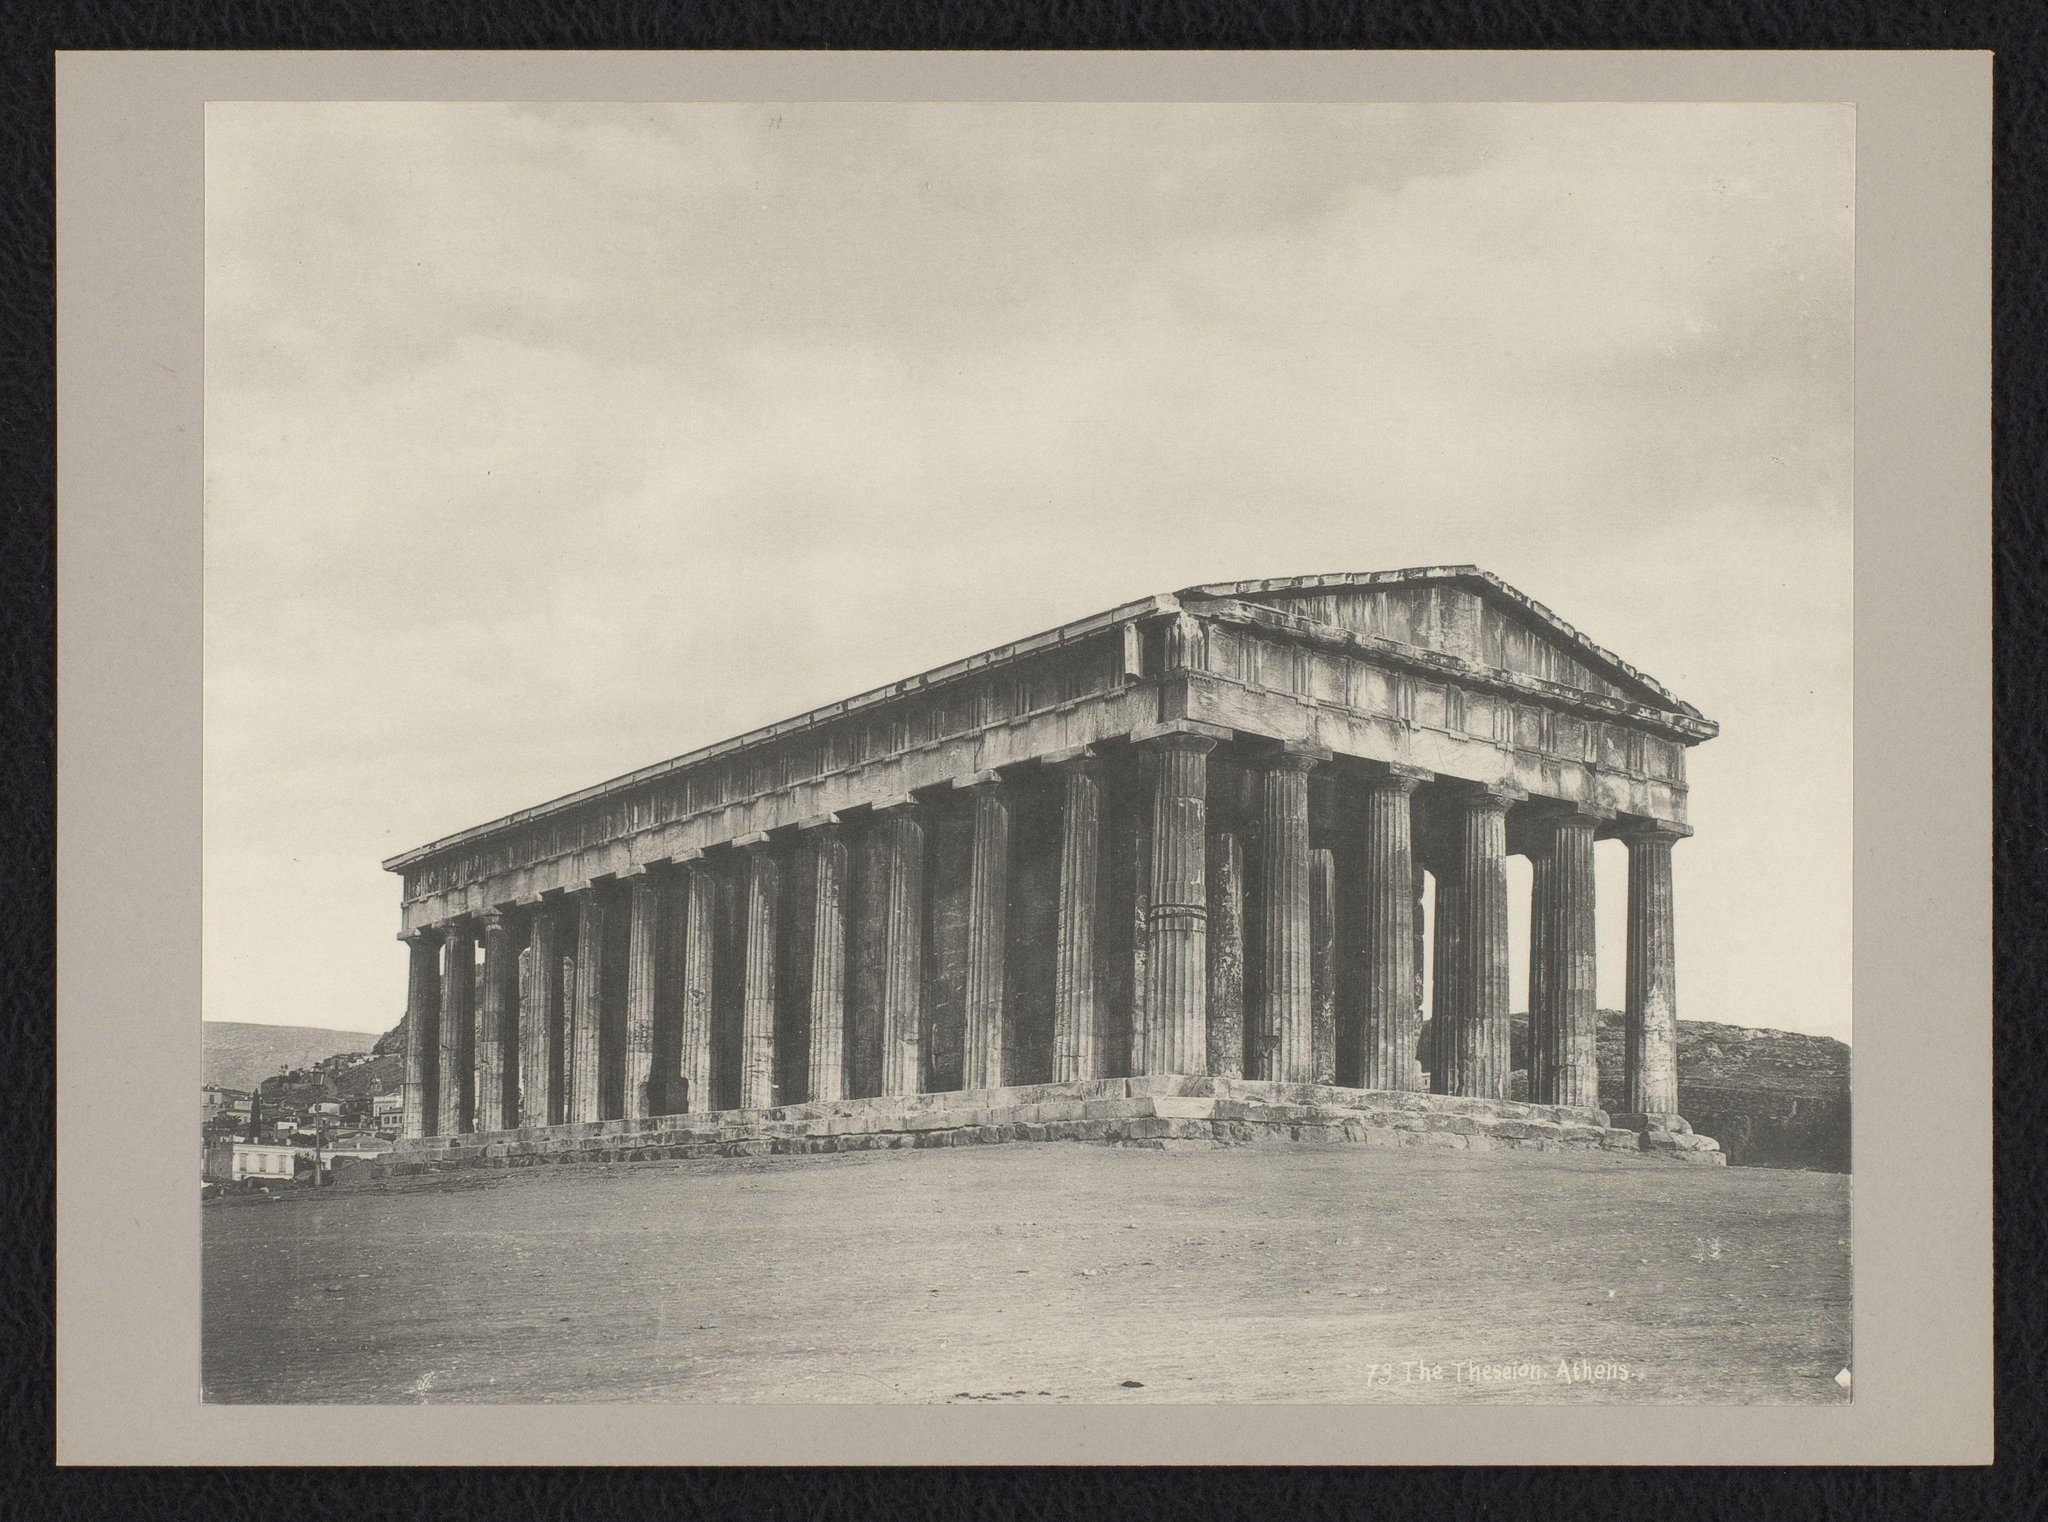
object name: photograph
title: Theseion, Athene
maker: Anonymous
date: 1895-1915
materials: cardboard, paper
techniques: photograph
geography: athens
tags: athene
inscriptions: number: ‘30.’